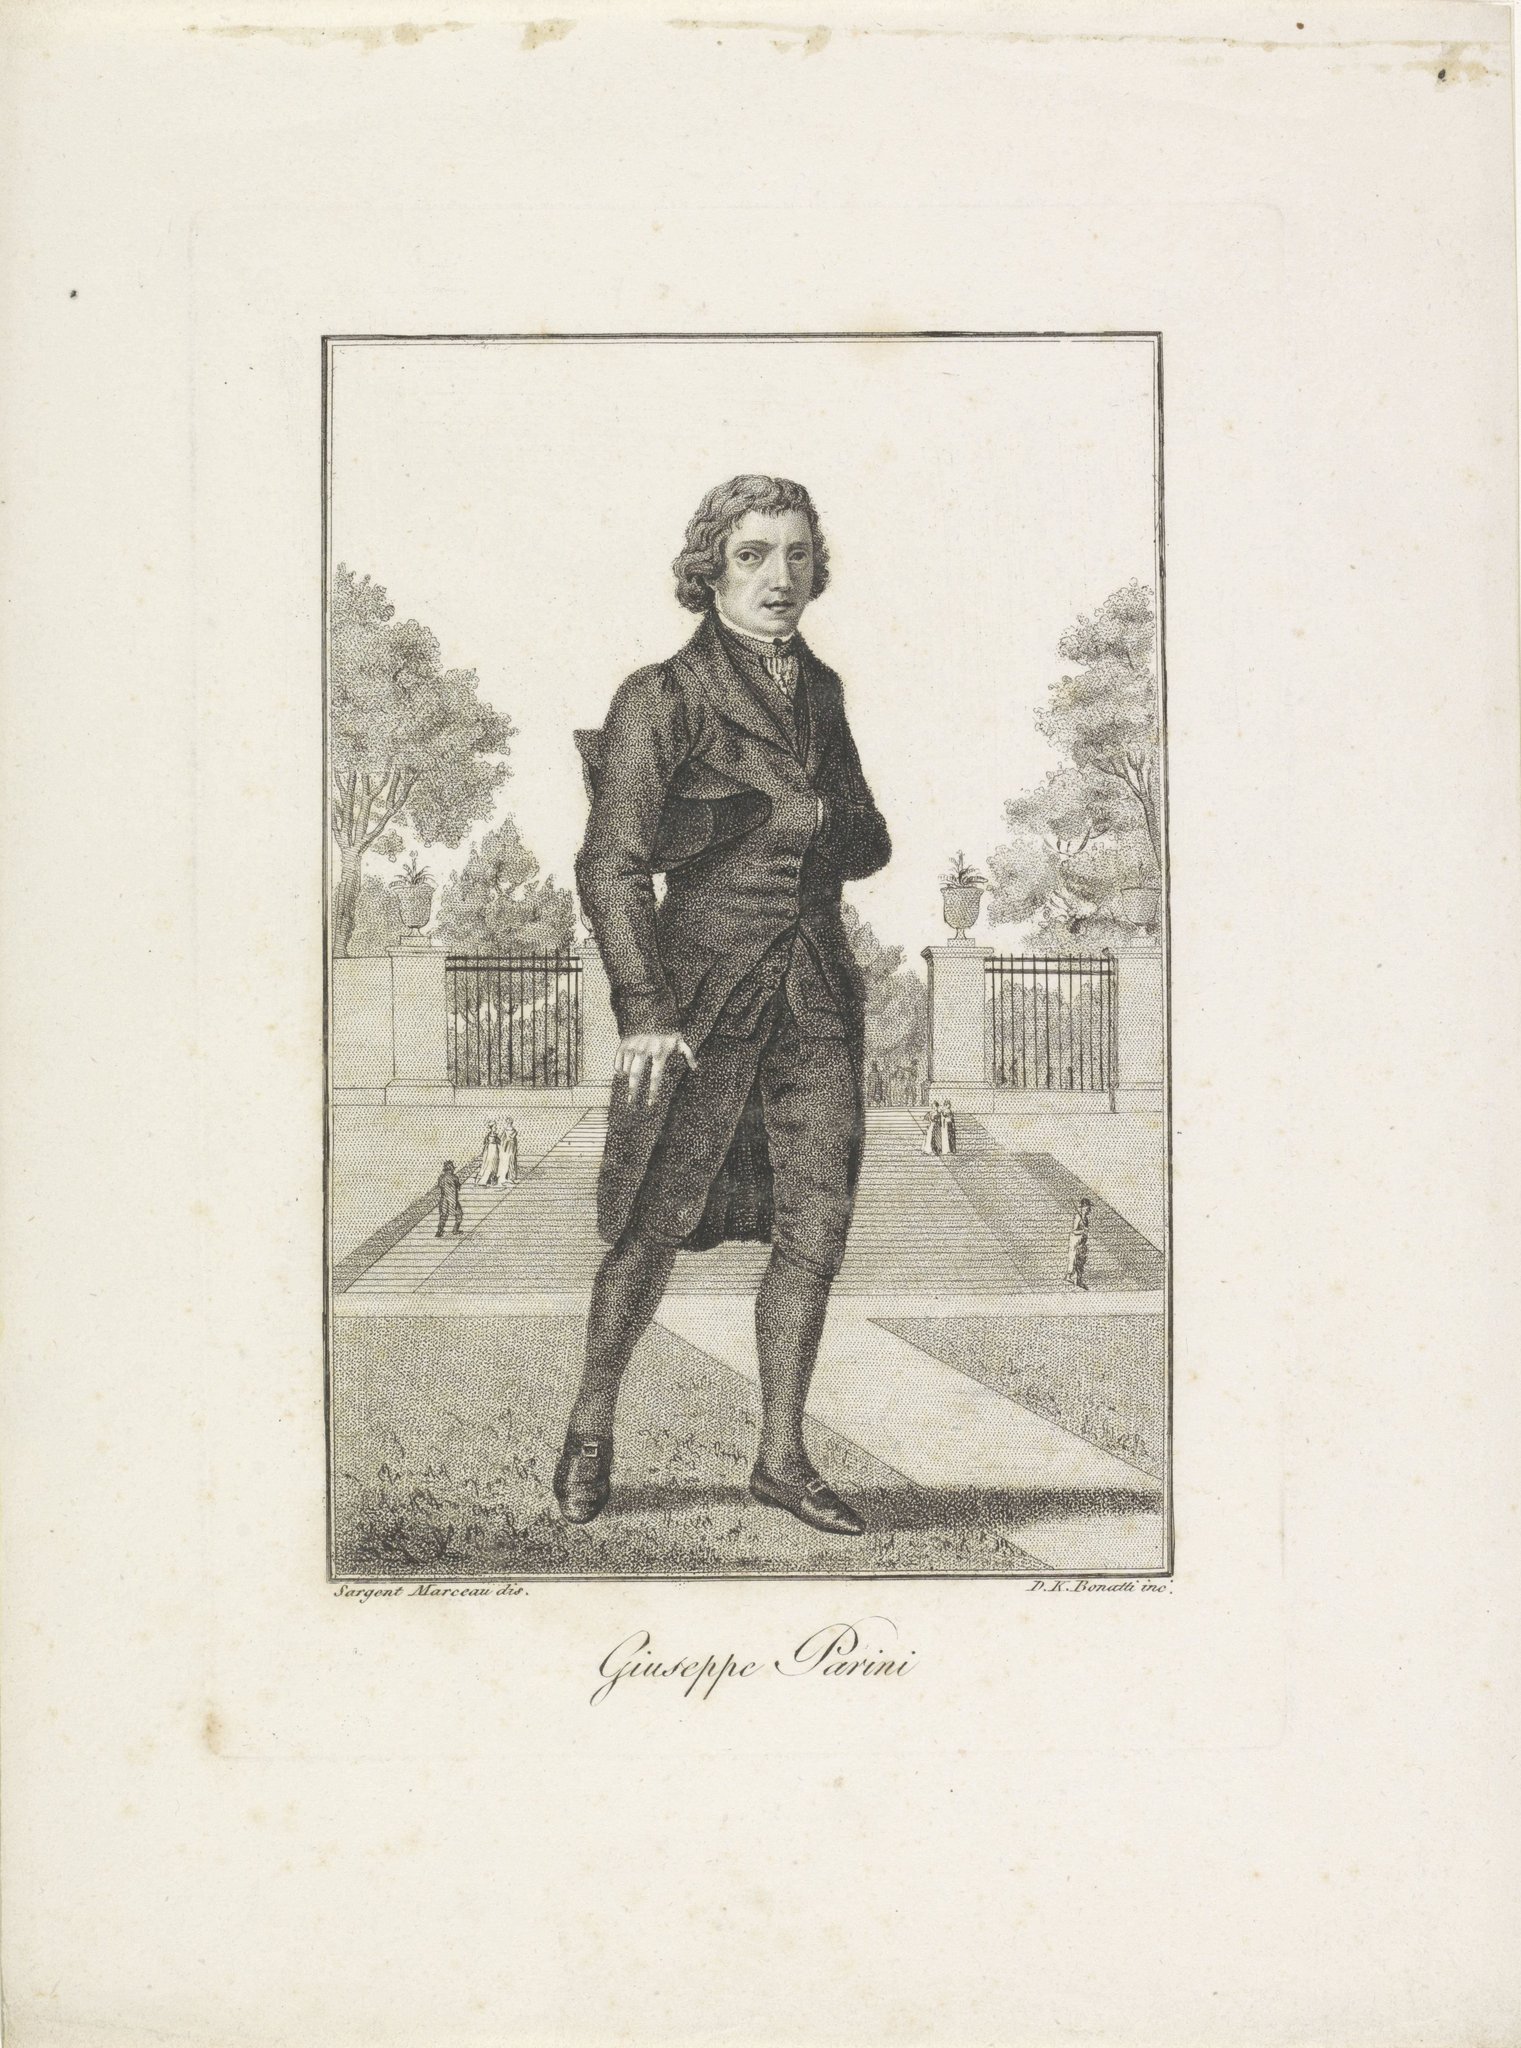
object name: print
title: Portret van Giuseppe Parini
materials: paper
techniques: etching, engraving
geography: italy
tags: historical persons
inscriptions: collector's mark: Lugt 2228